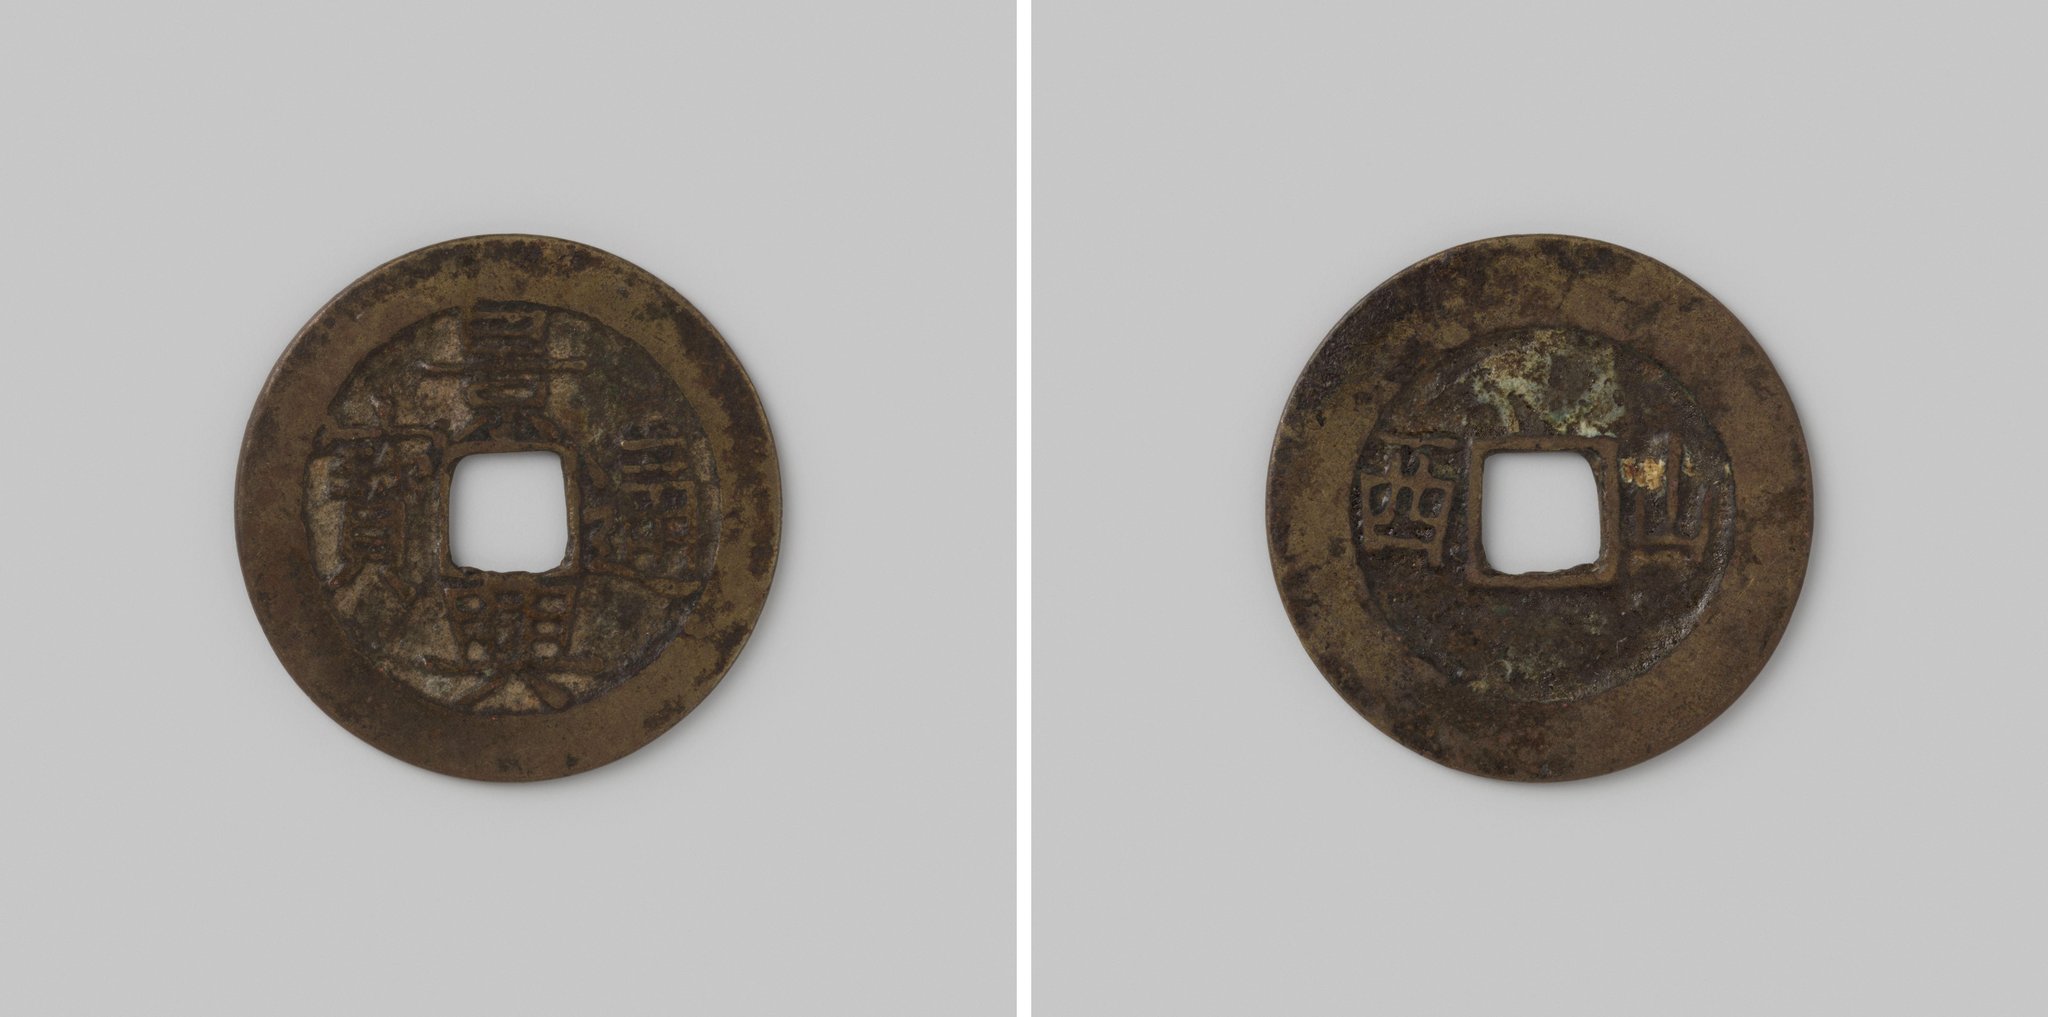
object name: coin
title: Keizerrijk Annam, tsjien of donga, Duy-dao, 1740-1786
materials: copper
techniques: striking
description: Koperen munt. Voorzijde: vier Chinese karakters rodom vierkante uitsparing in het midden. Keerzijde: glad.